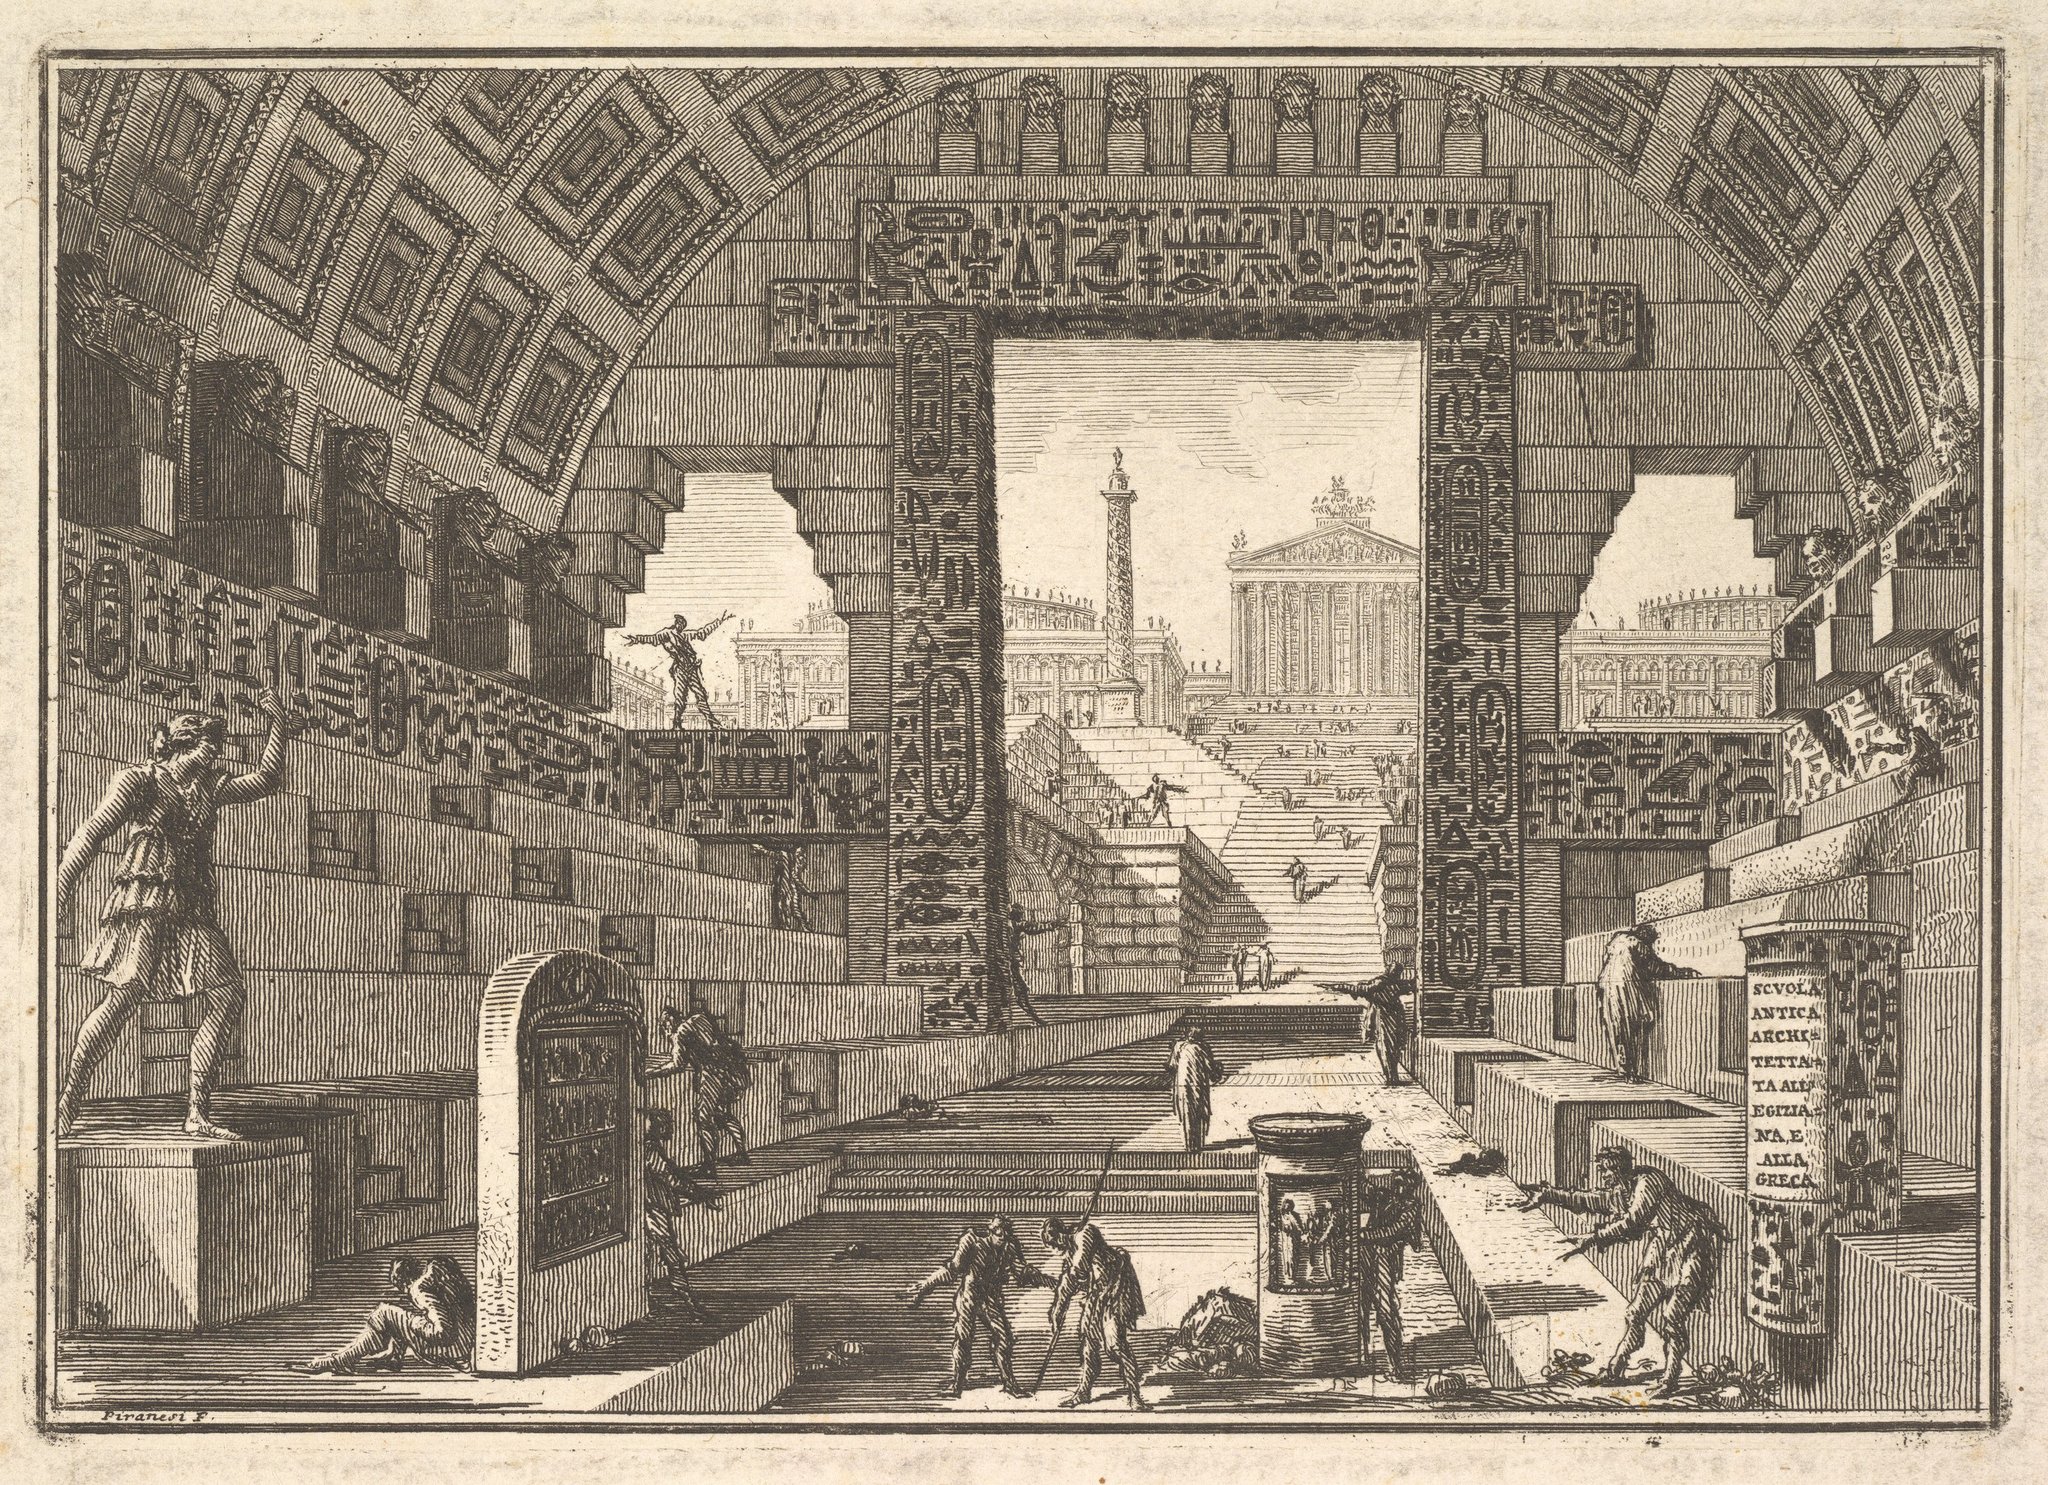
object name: print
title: Ancient school built according to the Egyptian and Greek manners (Scuola antica architettata all'Egiziana e alla Greca)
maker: giovanni battista piranesi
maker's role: artist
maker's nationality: italian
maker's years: 1720-1778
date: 1750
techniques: etching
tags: architecture,schools,men